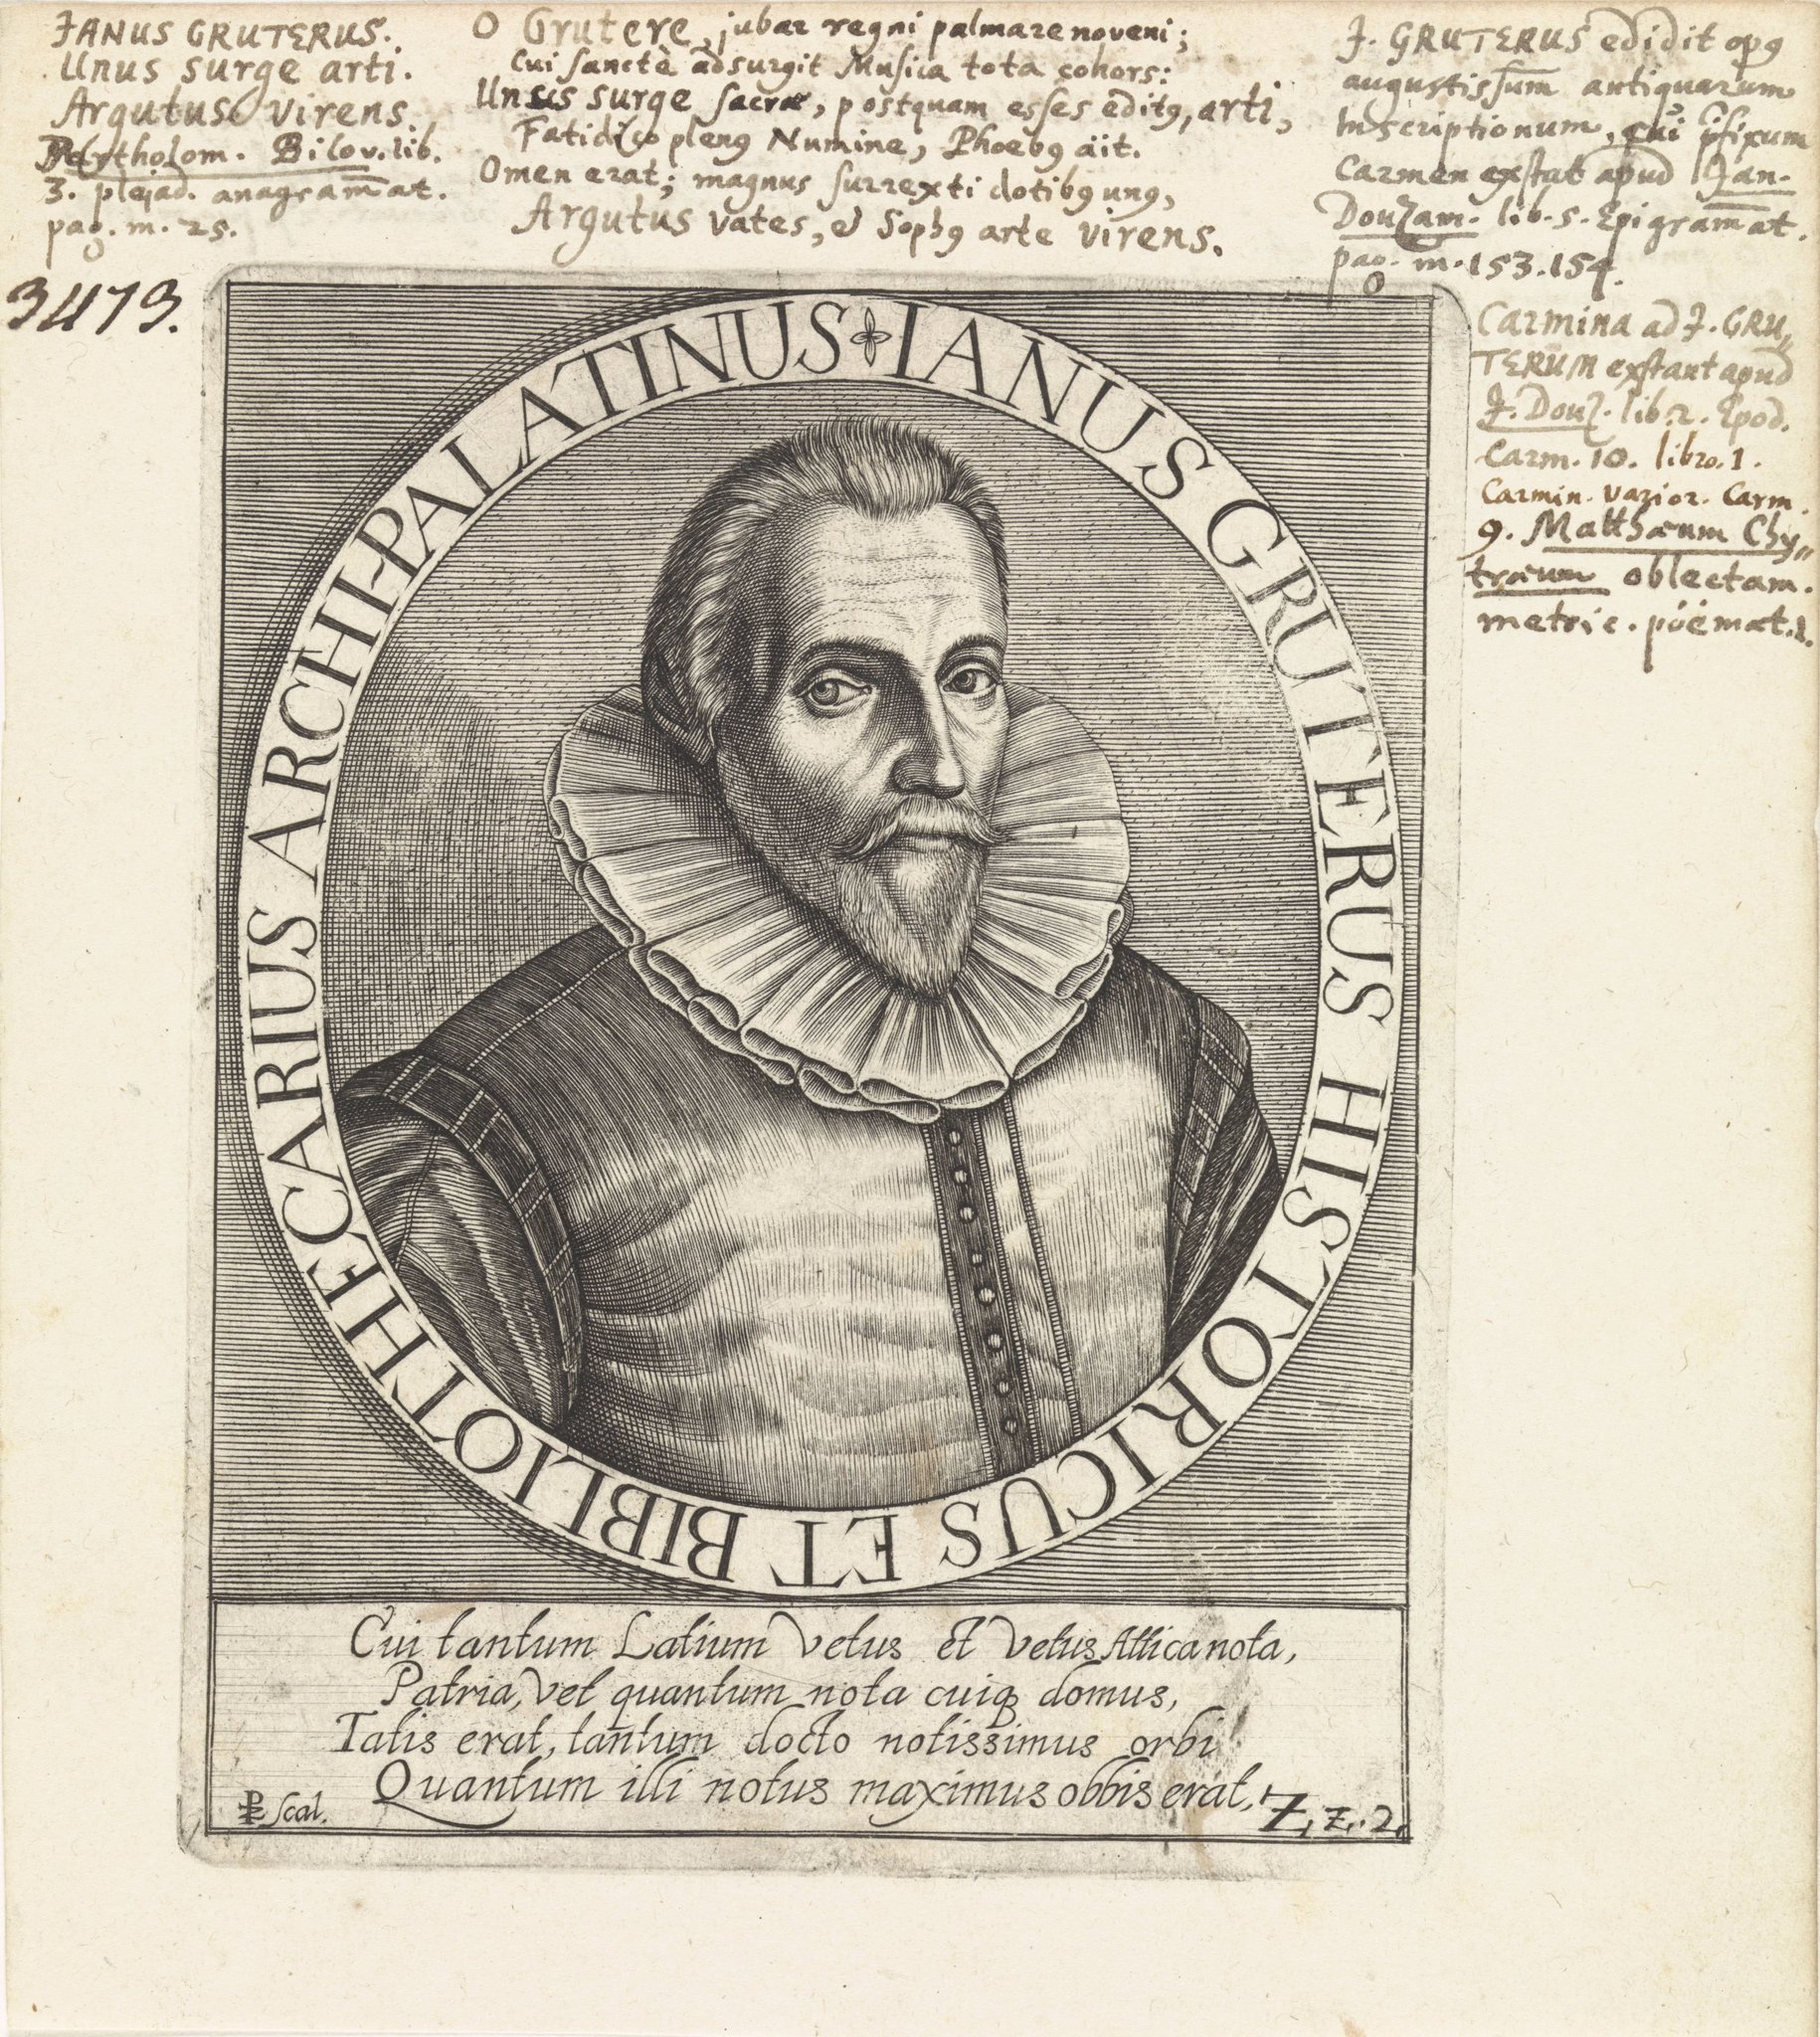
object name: print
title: Portretten van beroemde Europese wetenschappers, humanisten en geestelijken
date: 1650-1669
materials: paper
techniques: engraving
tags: antwerp, janus gruterus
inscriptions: collector's mark: Lugt 2228, inscription: ‘Janus Gruterus unus surge arti ...’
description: Prent gebruikt in een van de edities van Jean-Jacques Boissard. Boissard, Jean-Jacques. Bibliotheca sive Thesaurus Virtutis et Gloriae: In quo continentus Illvstrivm Ervditione & doctrina Virorum Effigies & Vitae (...). Frankfurt, [1628]. Zie Hollstein Dutch, deel LVIII, p. 86-87.